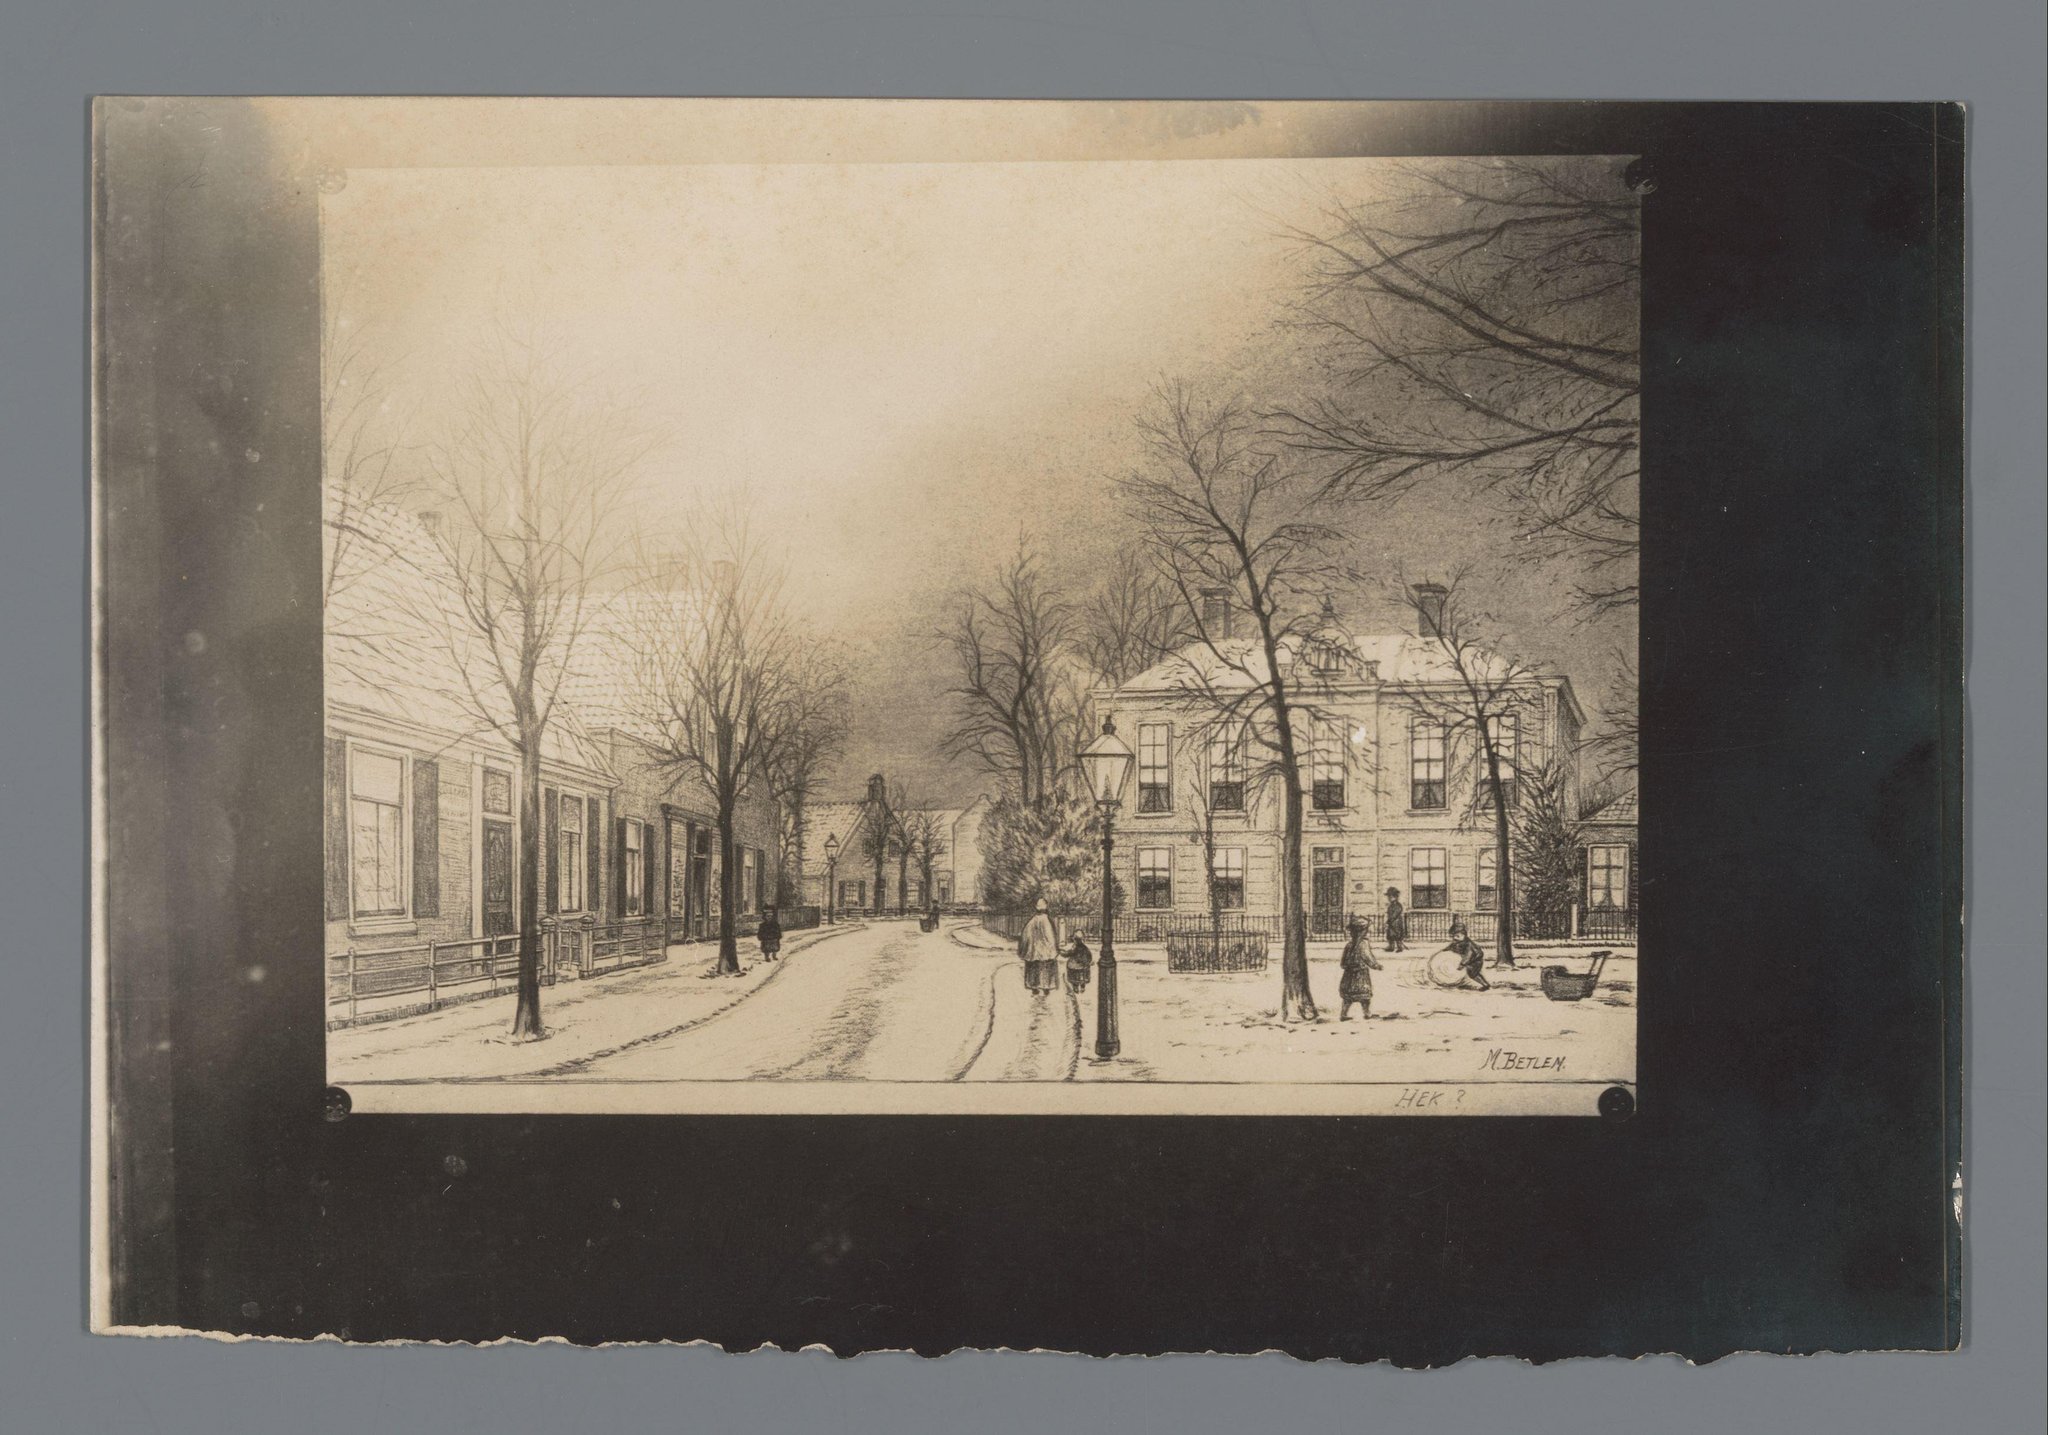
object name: photograph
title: Fotoreproductie van een schilderij van een gezicht te Hilversum door Maarten Betlem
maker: Anonymous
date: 1900-1930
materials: photographic support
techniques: gelatin silver print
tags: street (+ city(-scape) with figures, staffage)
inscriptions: inscription: ‘Vosmaer’, annotation: ‘Hilversum’